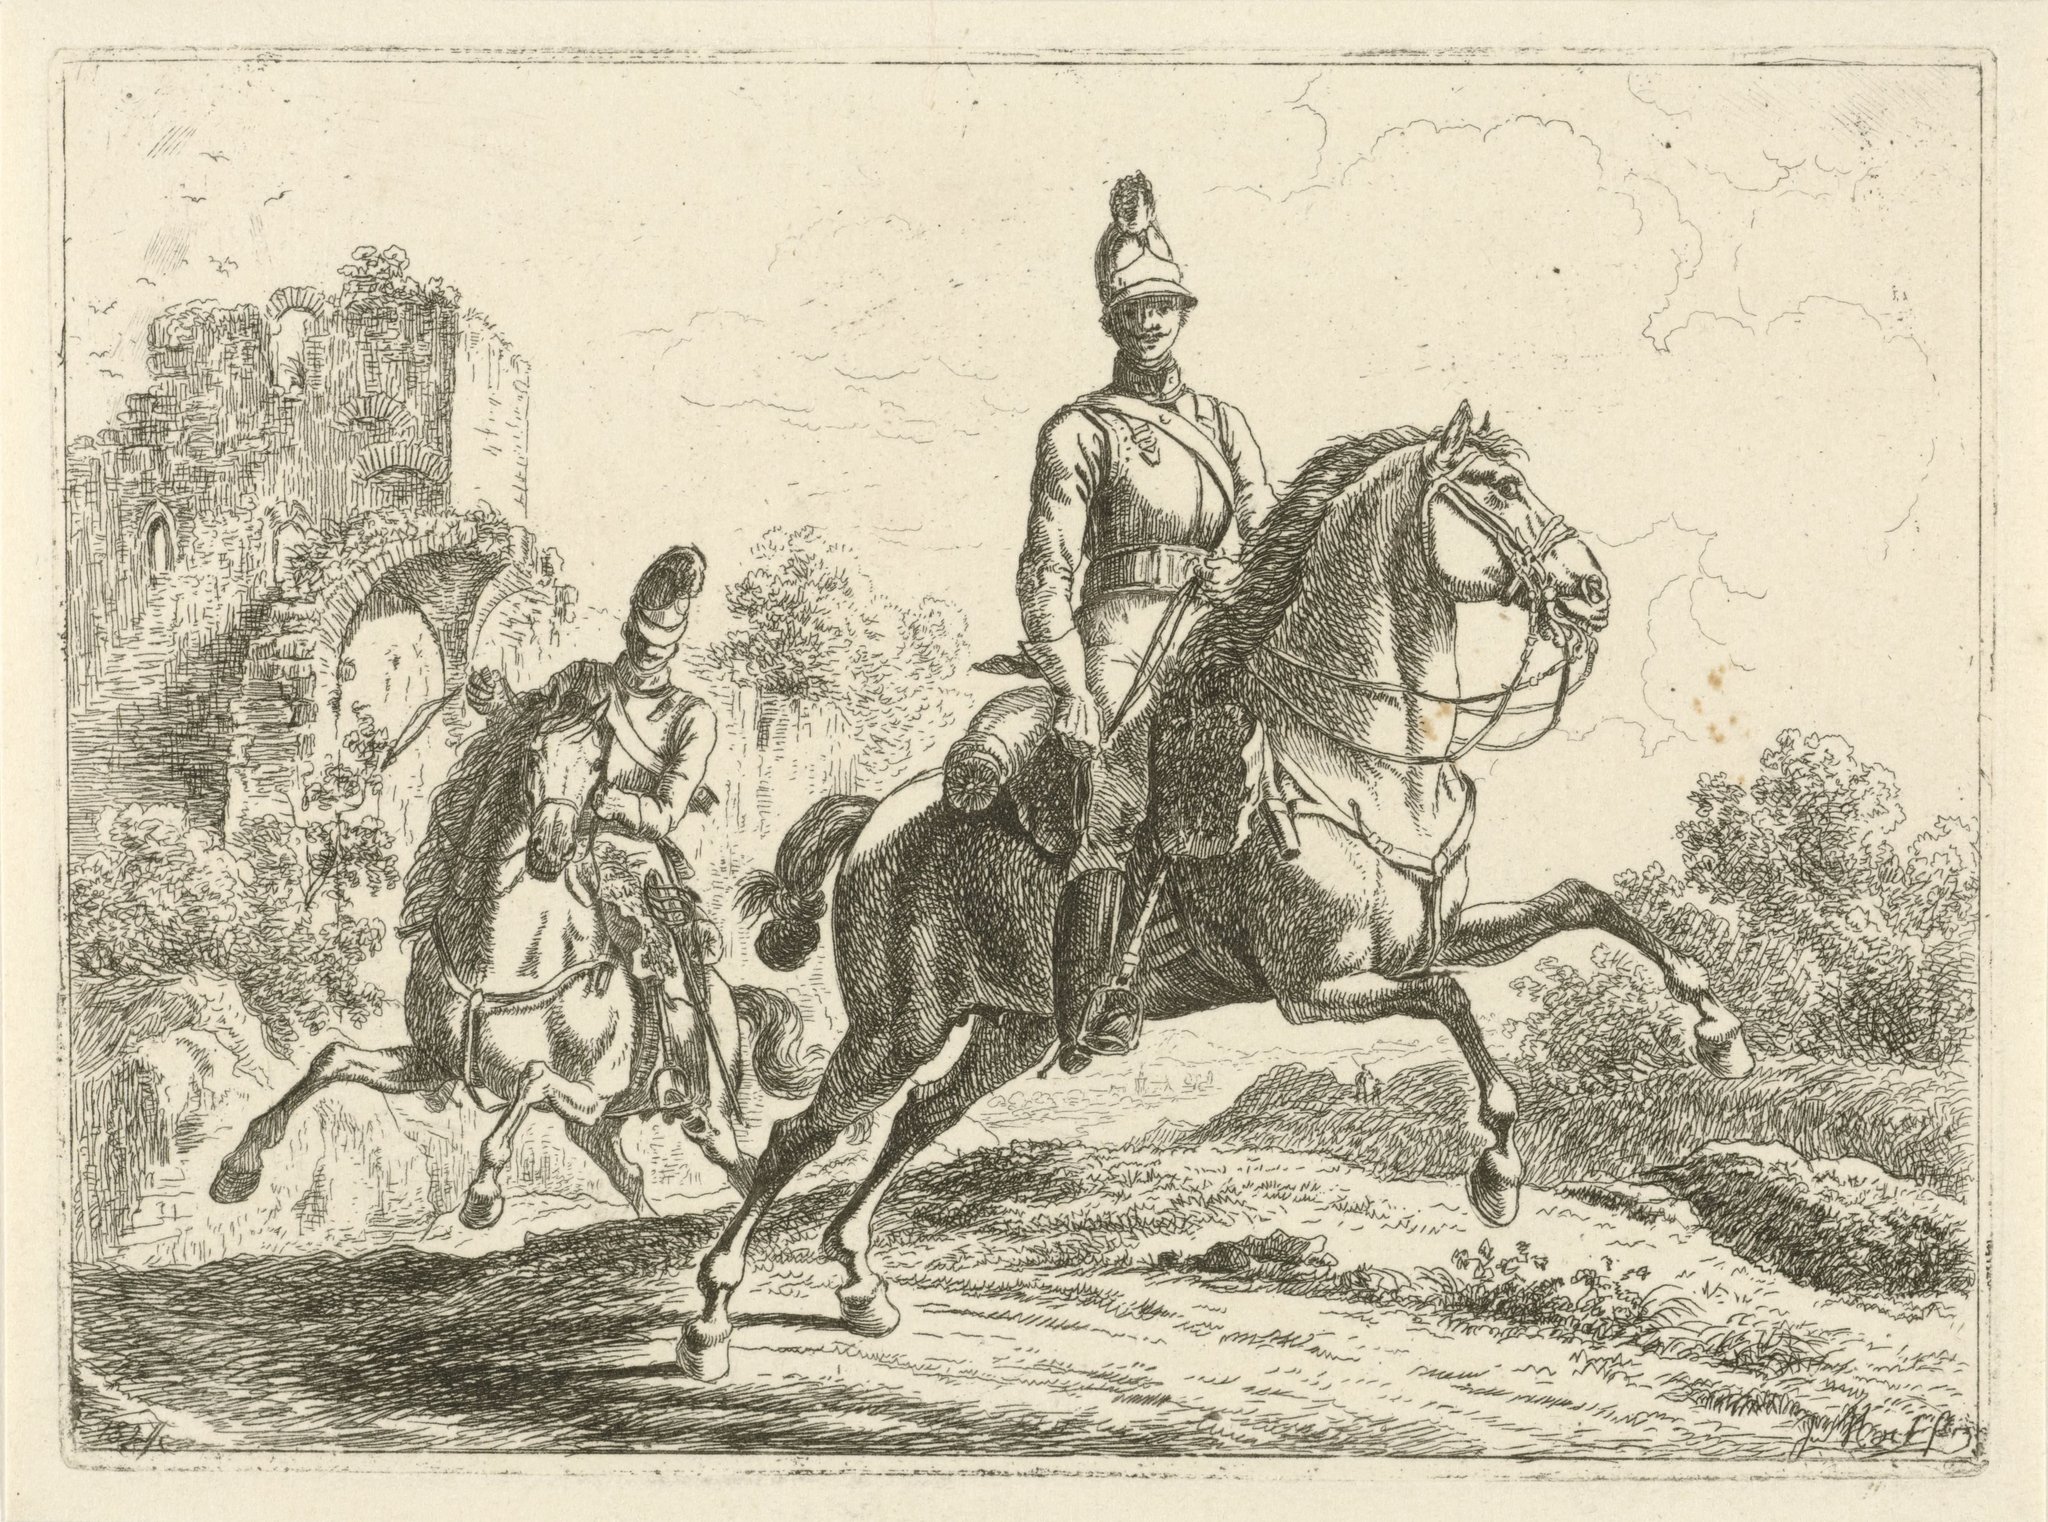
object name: print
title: Twee soldaten te paard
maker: johannes mock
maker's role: draughtsman, painter, print maker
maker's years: 1800-1884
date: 1821-1827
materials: paper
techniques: etching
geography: netherlands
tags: land forces (+ cavalry, horsemen), landscape with ruins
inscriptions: collector's mark: Lugt 2228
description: Landschap met twee soldaten te paard en links een ruïne.